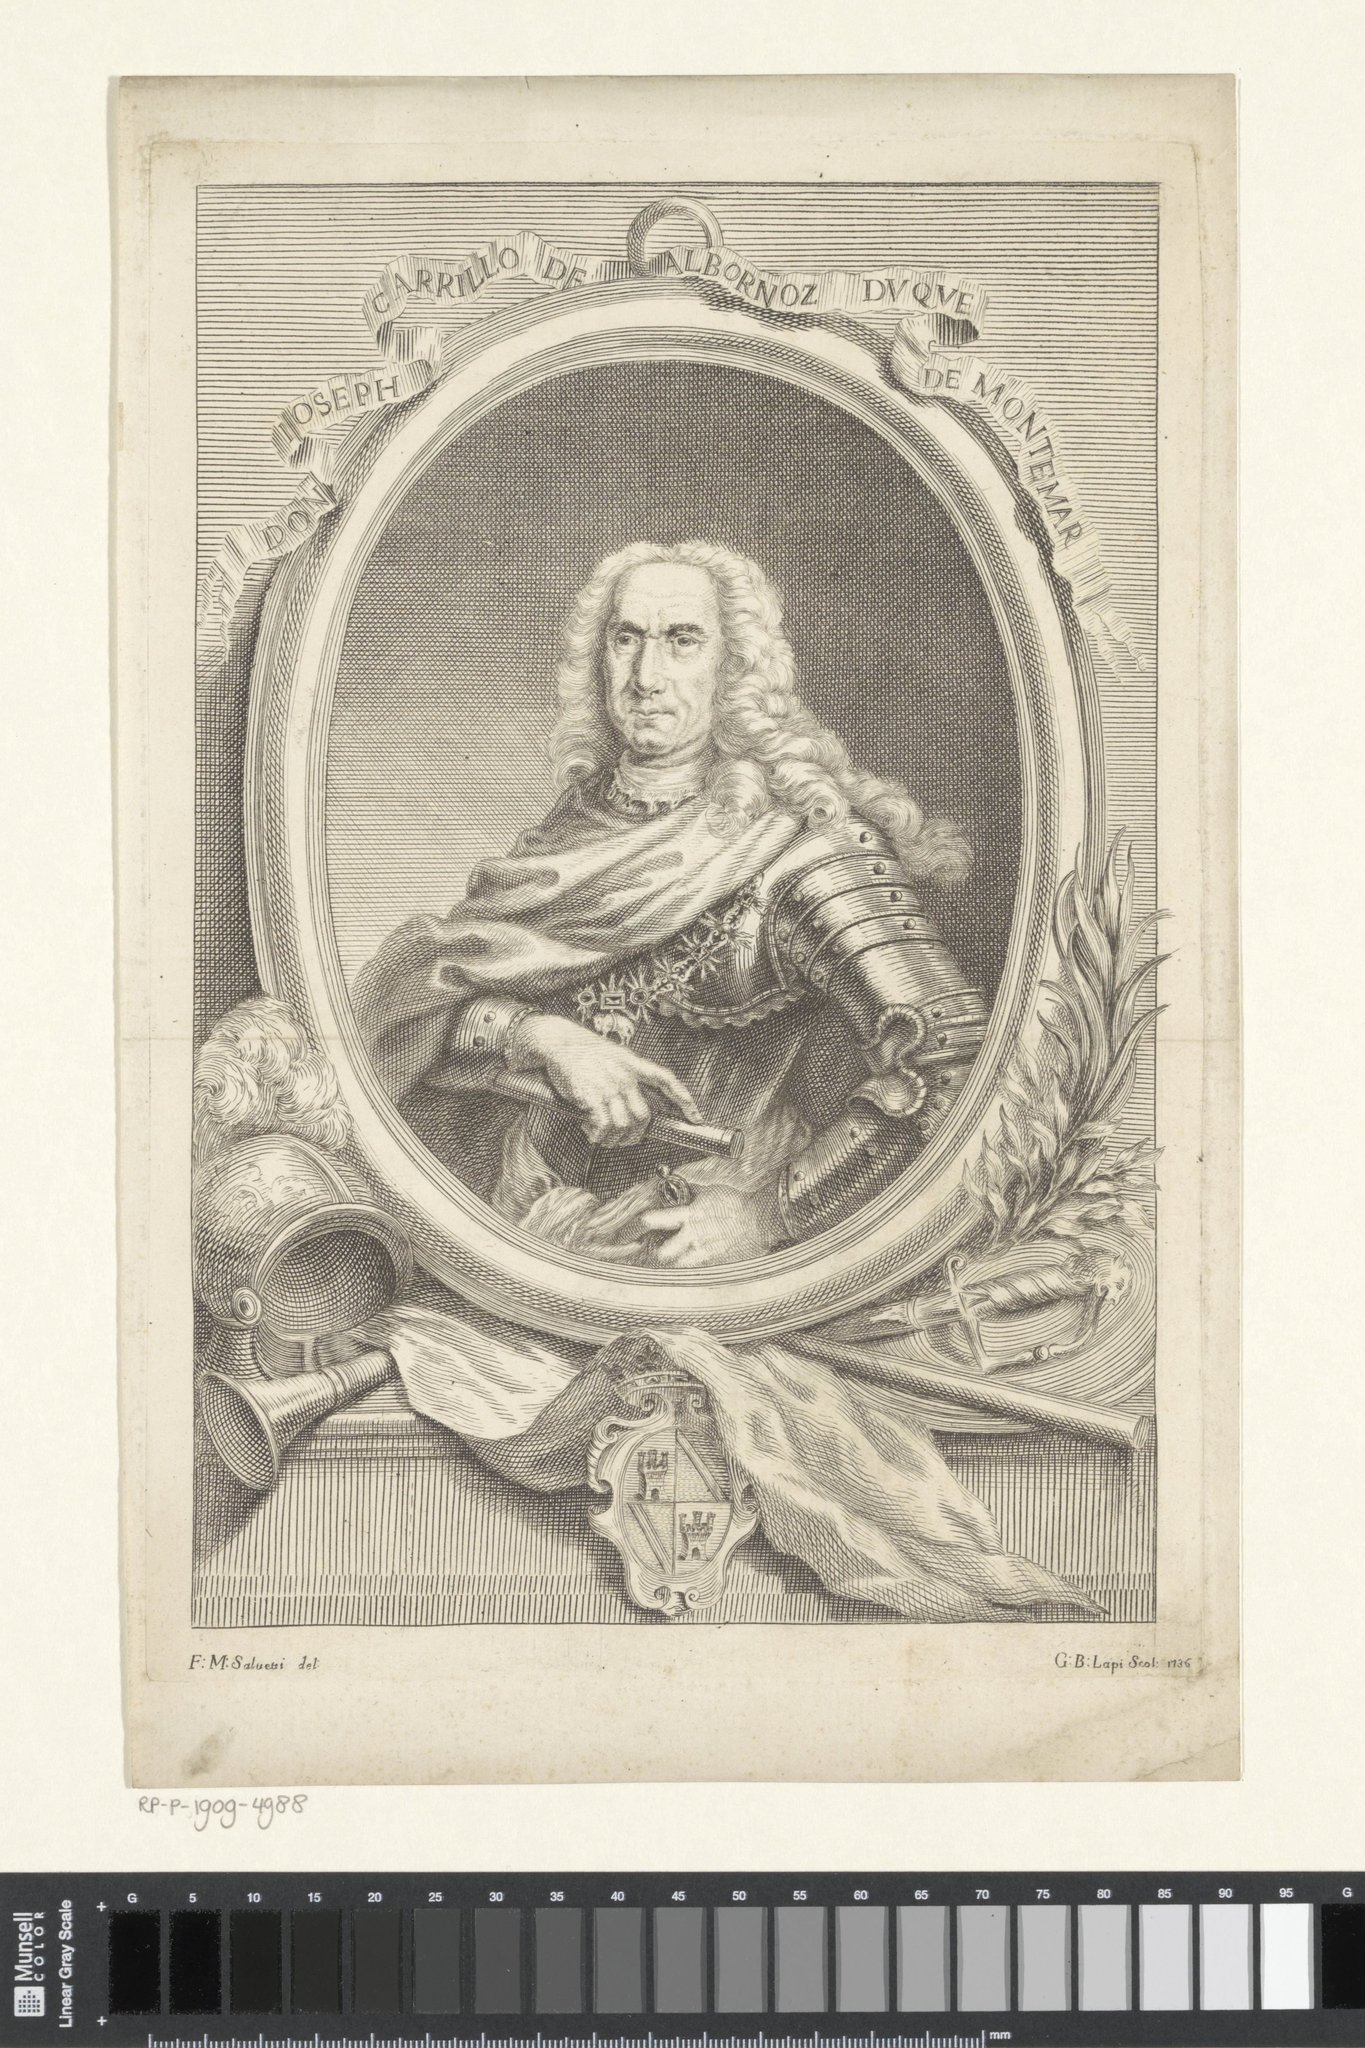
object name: print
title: Portret van militair José Carrillo de Albornoz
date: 1736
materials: paper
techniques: engraving, etching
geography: italy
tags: sevilla, historical persons, the soldier; the soldier's life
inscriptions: collector's mark: Lugt 2228